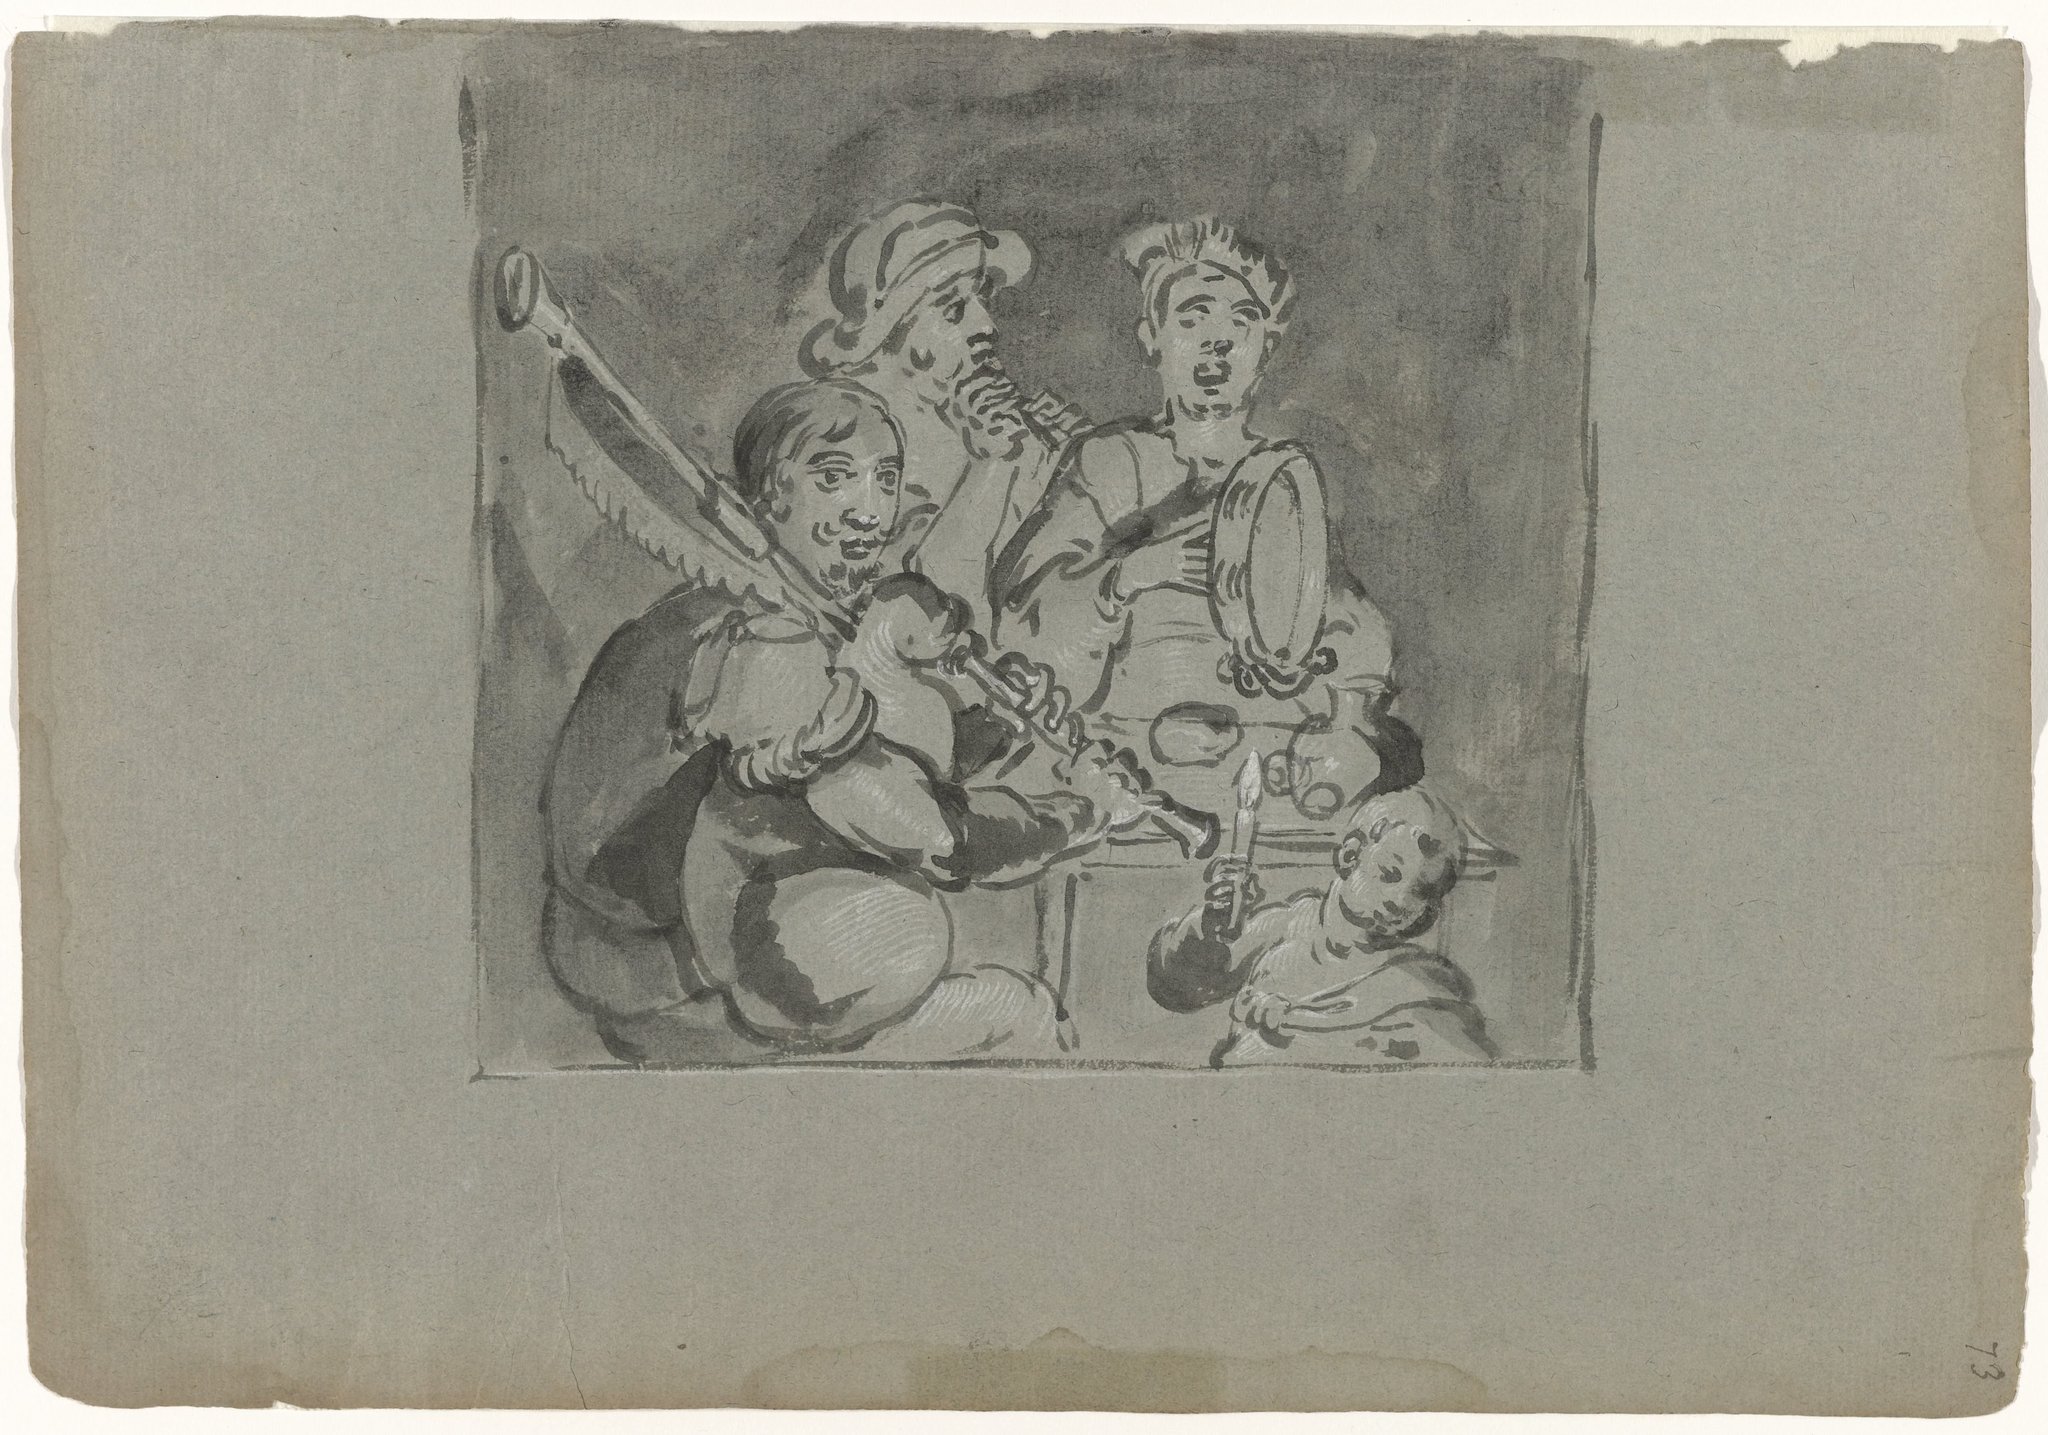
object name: drawing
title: Musicerend gezelschap bij kaarslicht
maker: leonaert bramer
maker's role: draughtsman, painter, print maker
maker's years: 1596-1674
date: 1616-1628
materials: paper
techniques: brush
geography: italy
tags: small group of musicians, chamber orchestra, jazz band, candle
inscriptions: number: ‘73’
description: Musicerend gezelschap rond een tafel bestaande uit een doedelzakspeler, een fluitist, een zanger met een tamboerijn en een kleine jongen met een kaars. Getekend op schetsboekblad van blauwgrijs papier, genummerd 73.